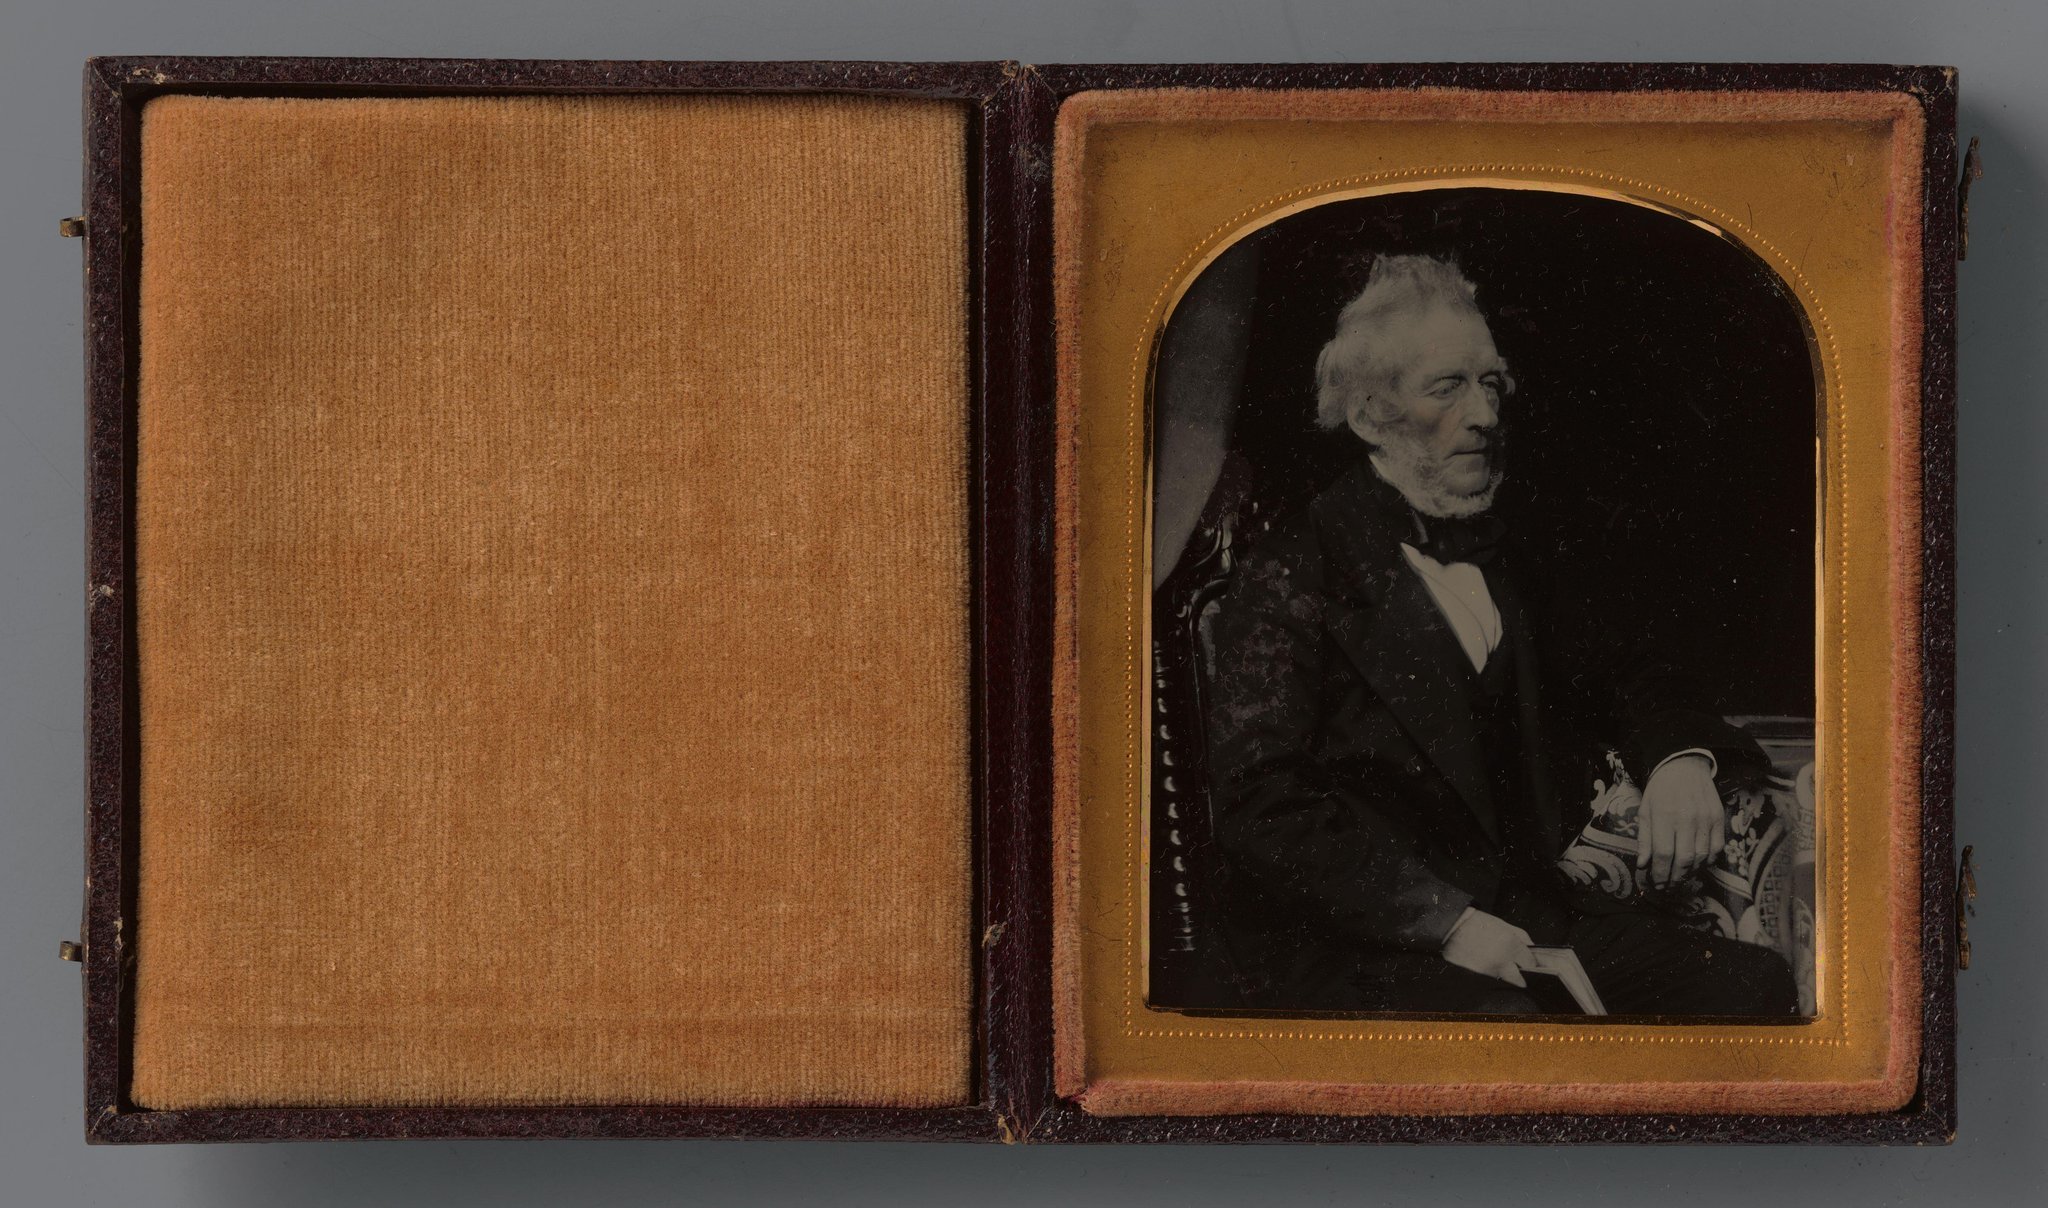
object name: photograph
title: Portret van een onbekende oude man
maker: Anonymous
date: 1855-1870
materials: glass, metal, velvet, wood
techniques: ambrotype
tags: sitting figure, historical persons, old man